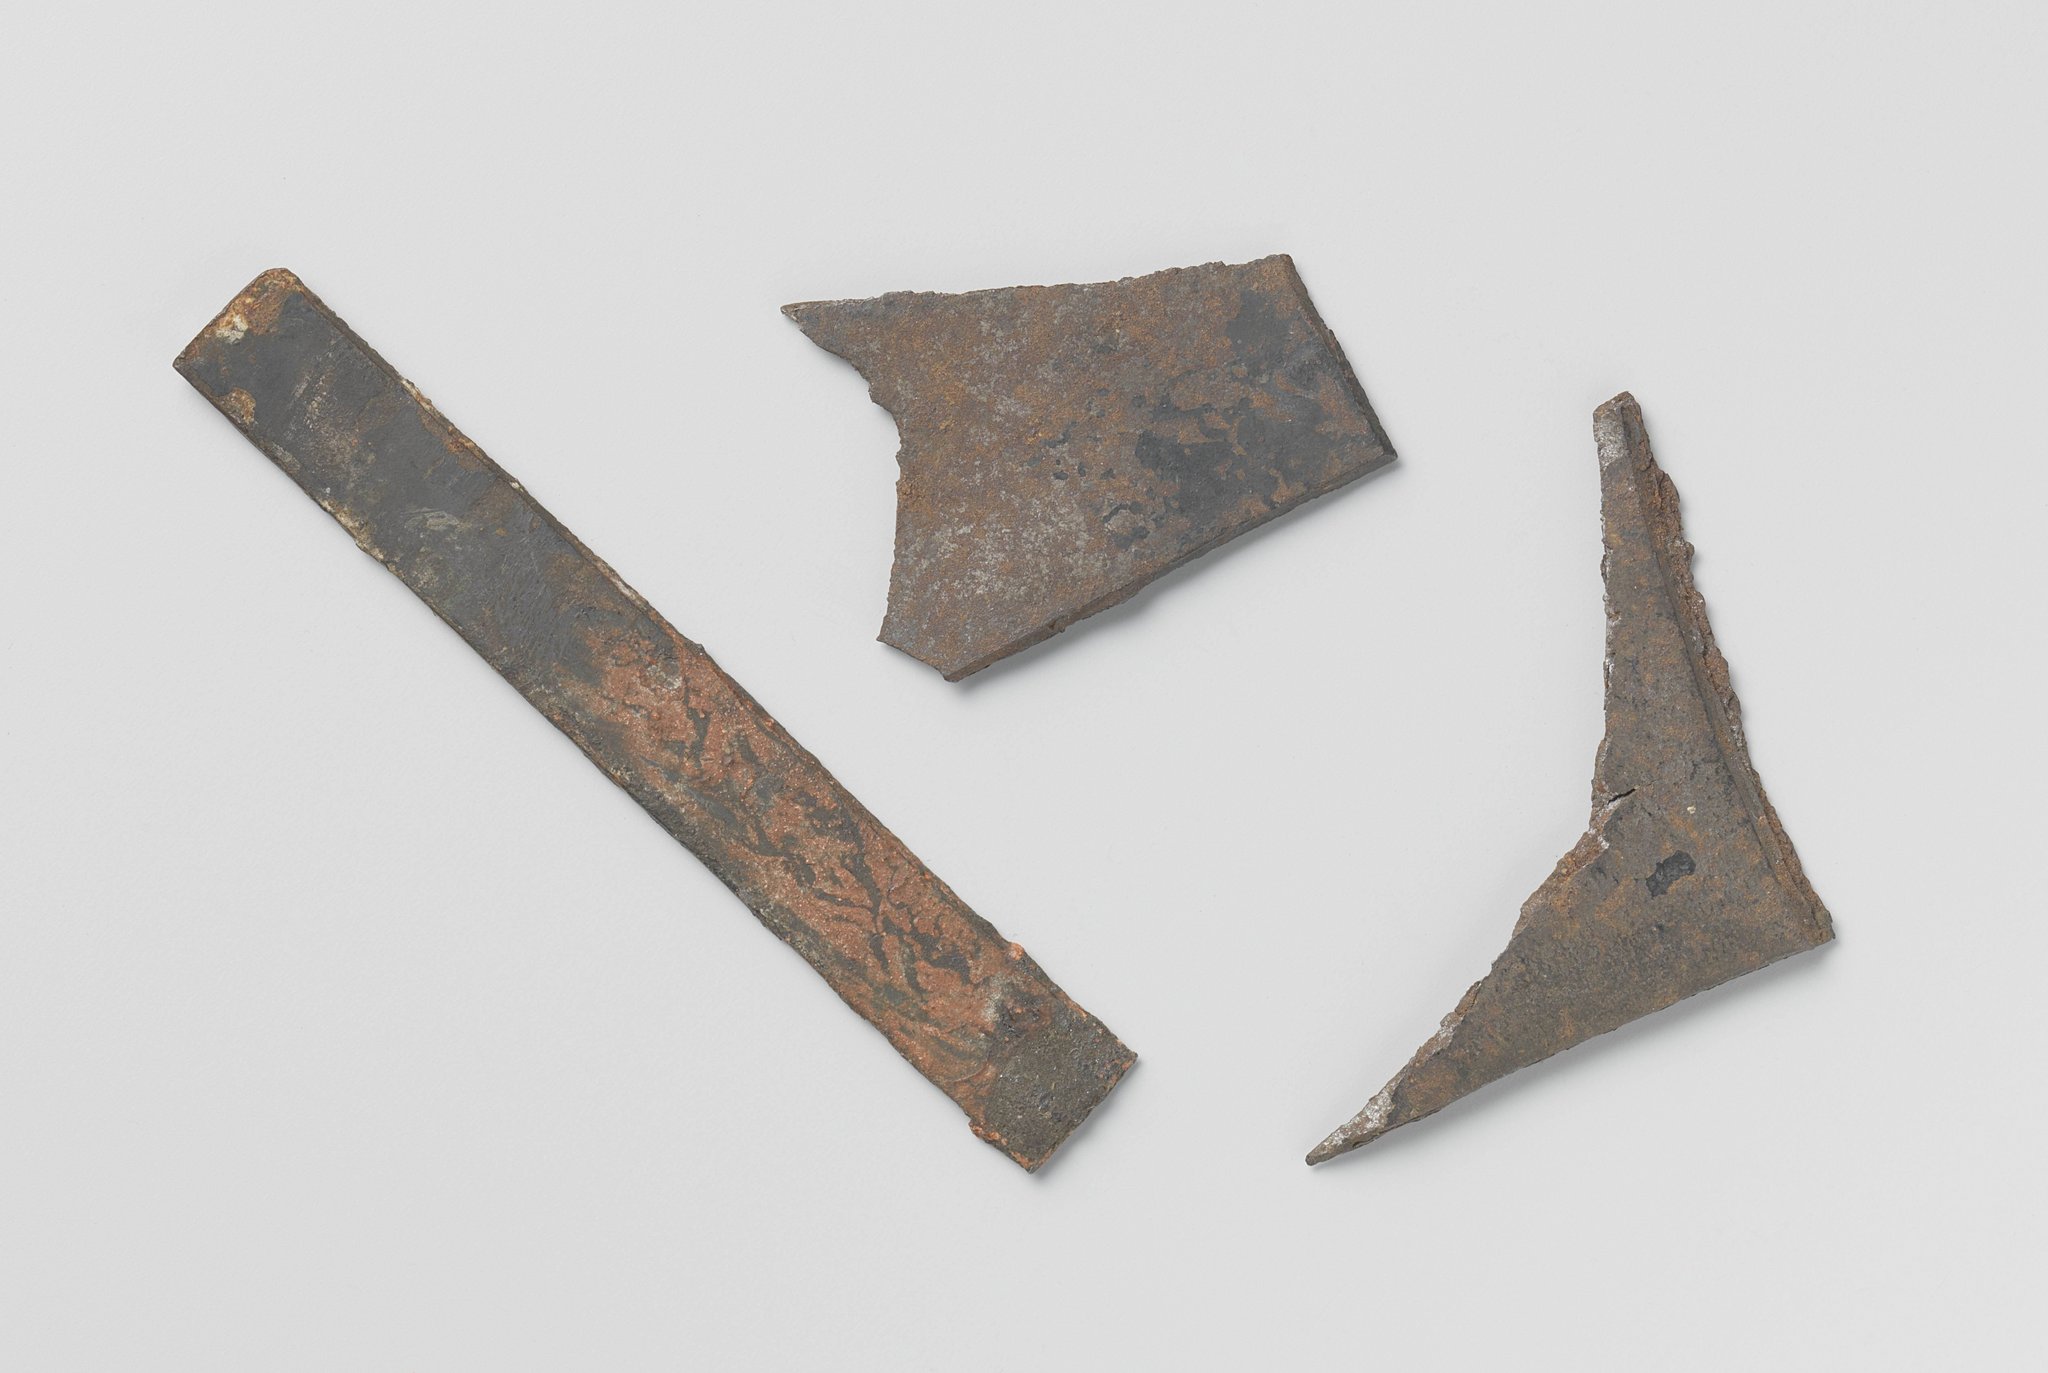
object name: fragment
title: Drie stukken ijzer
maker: Anonymous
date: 1831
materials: iron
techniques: forging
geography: netherlands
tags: amsterdam, antwerp, jan van speyk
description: Drie stukjes ijzer van zeer onregelmatige vorm.